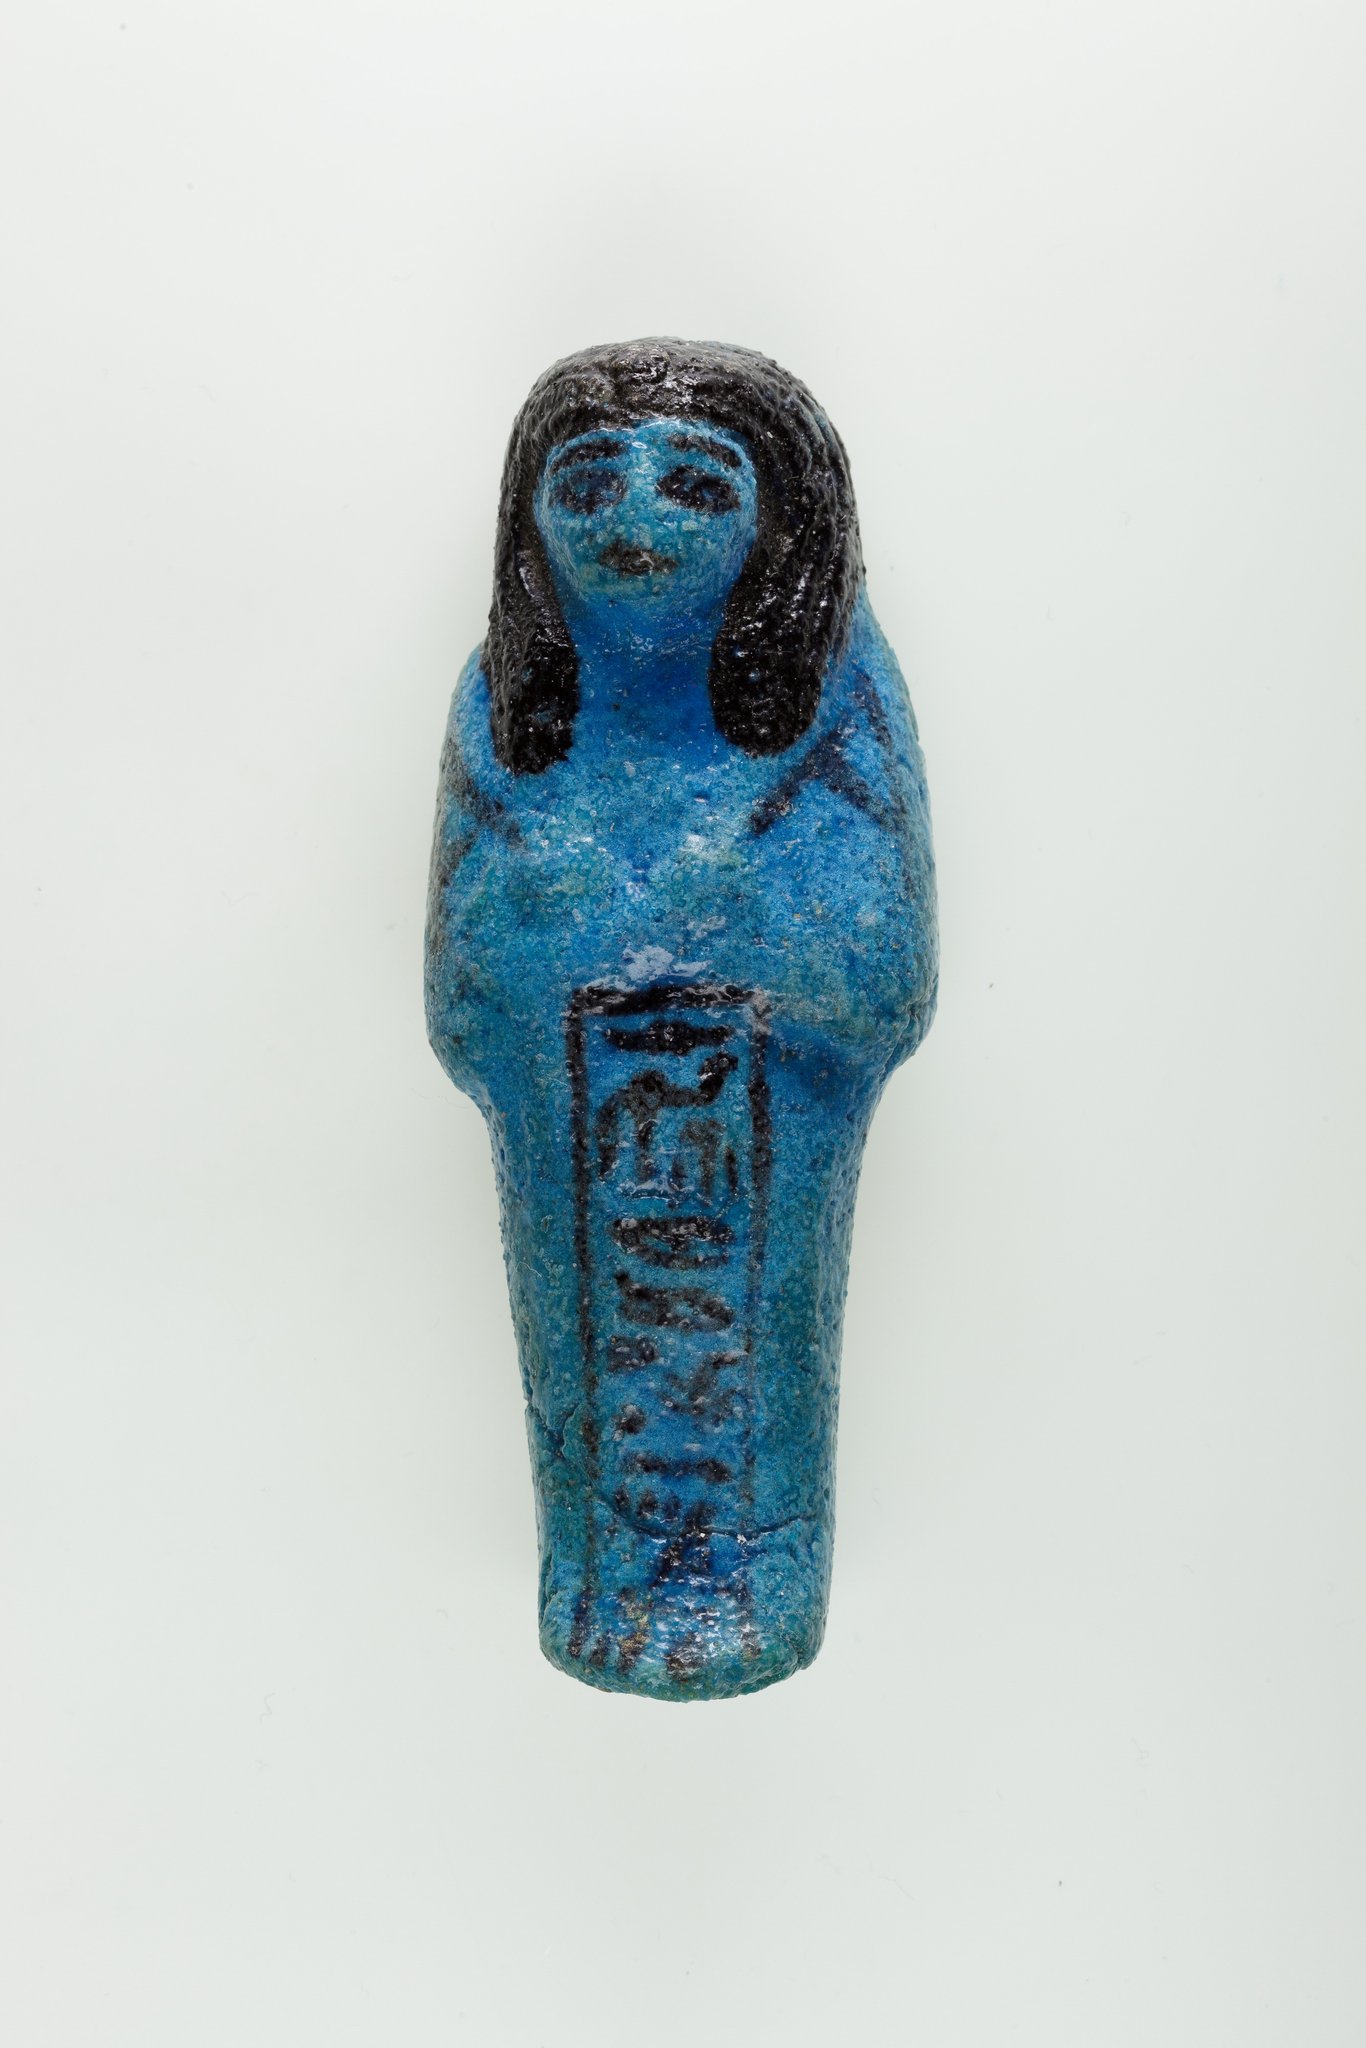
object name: shabti, worker, nauny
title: Worker Shabti of Nauny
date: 1050 BCE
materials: faience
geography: egypt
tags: hieroglyphs